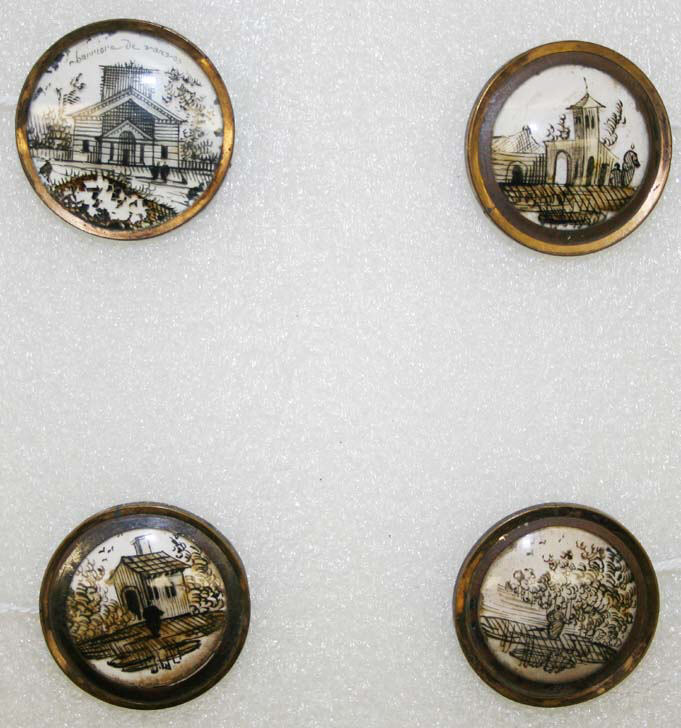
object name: button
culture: french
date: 1780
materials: glass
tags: buildings